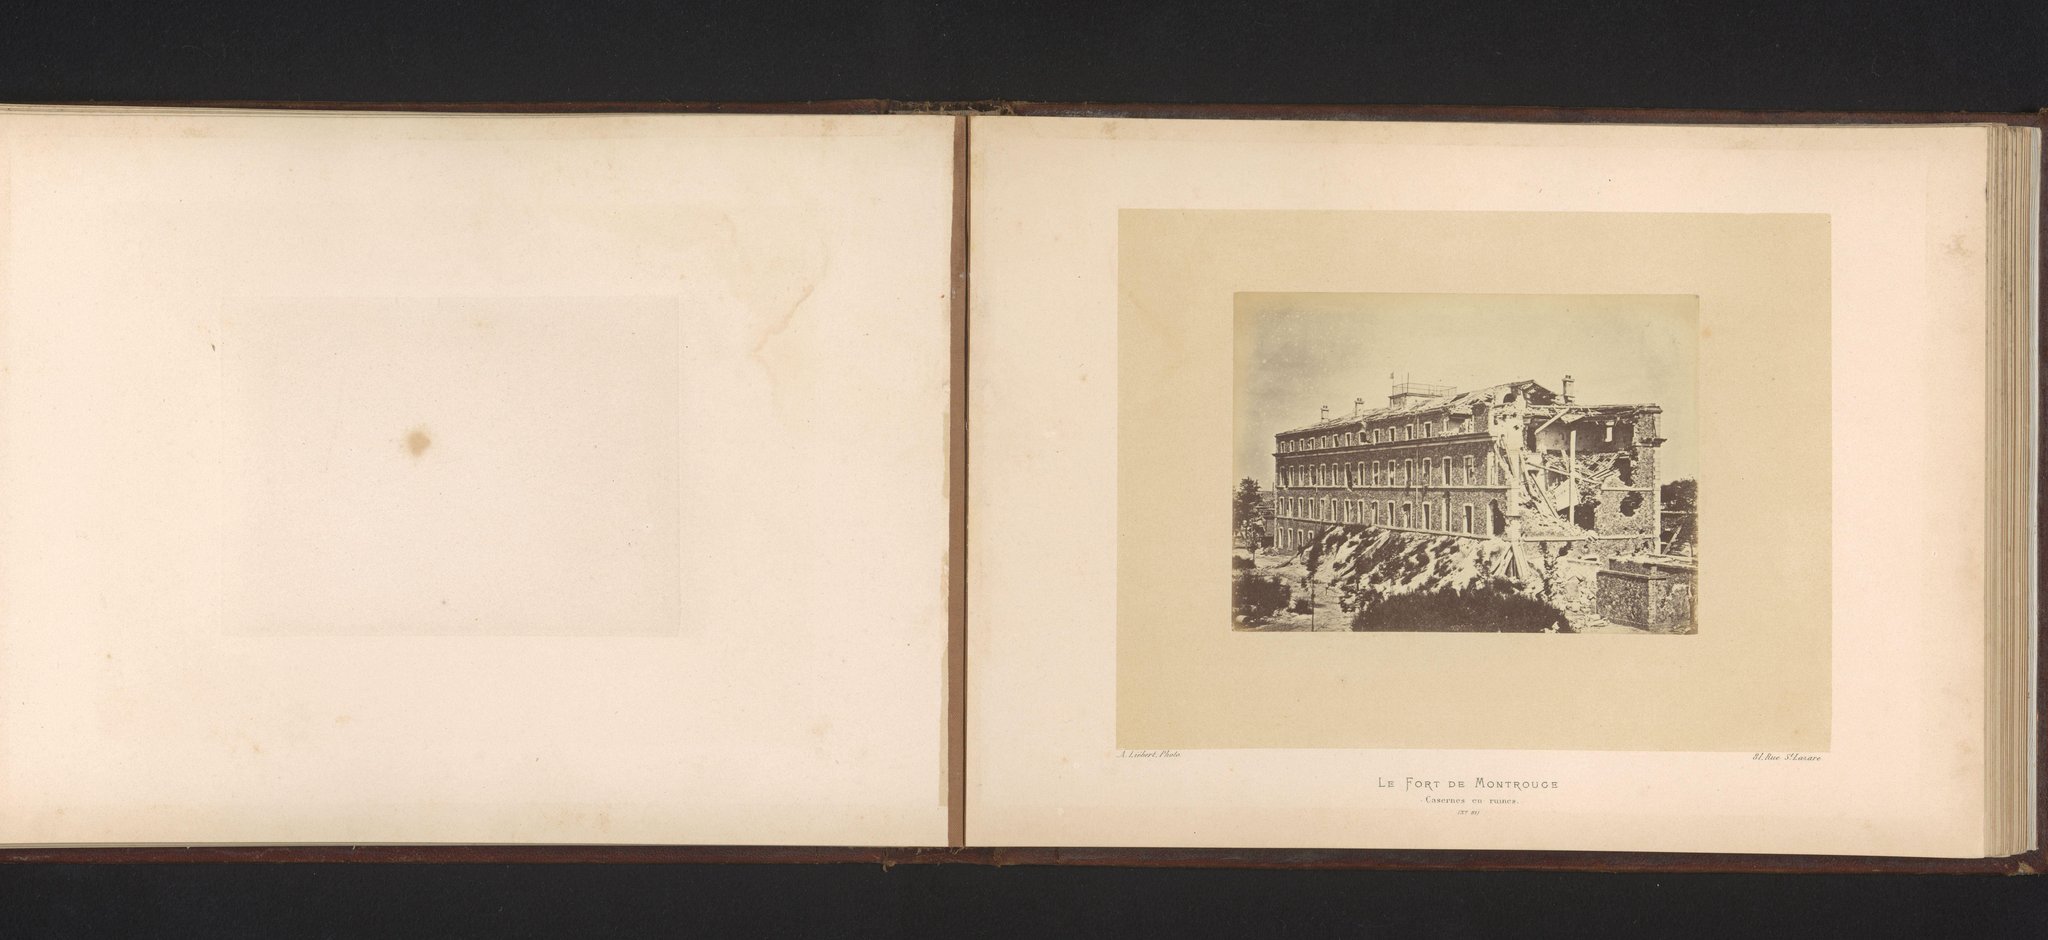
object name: page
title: Gezicht op resten van een barak van Fort de Montrouge in Arcueil na de verwoesting door de Commune van Parijs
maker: alphonse-justin liébert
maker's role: fotograaf, marinier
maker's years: 1827-1914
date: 1871-1872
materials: photographic support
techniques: albumen print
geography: arcueil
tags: fortress, ruin of a building ~ architecture, barracks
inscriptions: address: ‘31, Rue St. Lazare’, number: ‘(No. 81)’